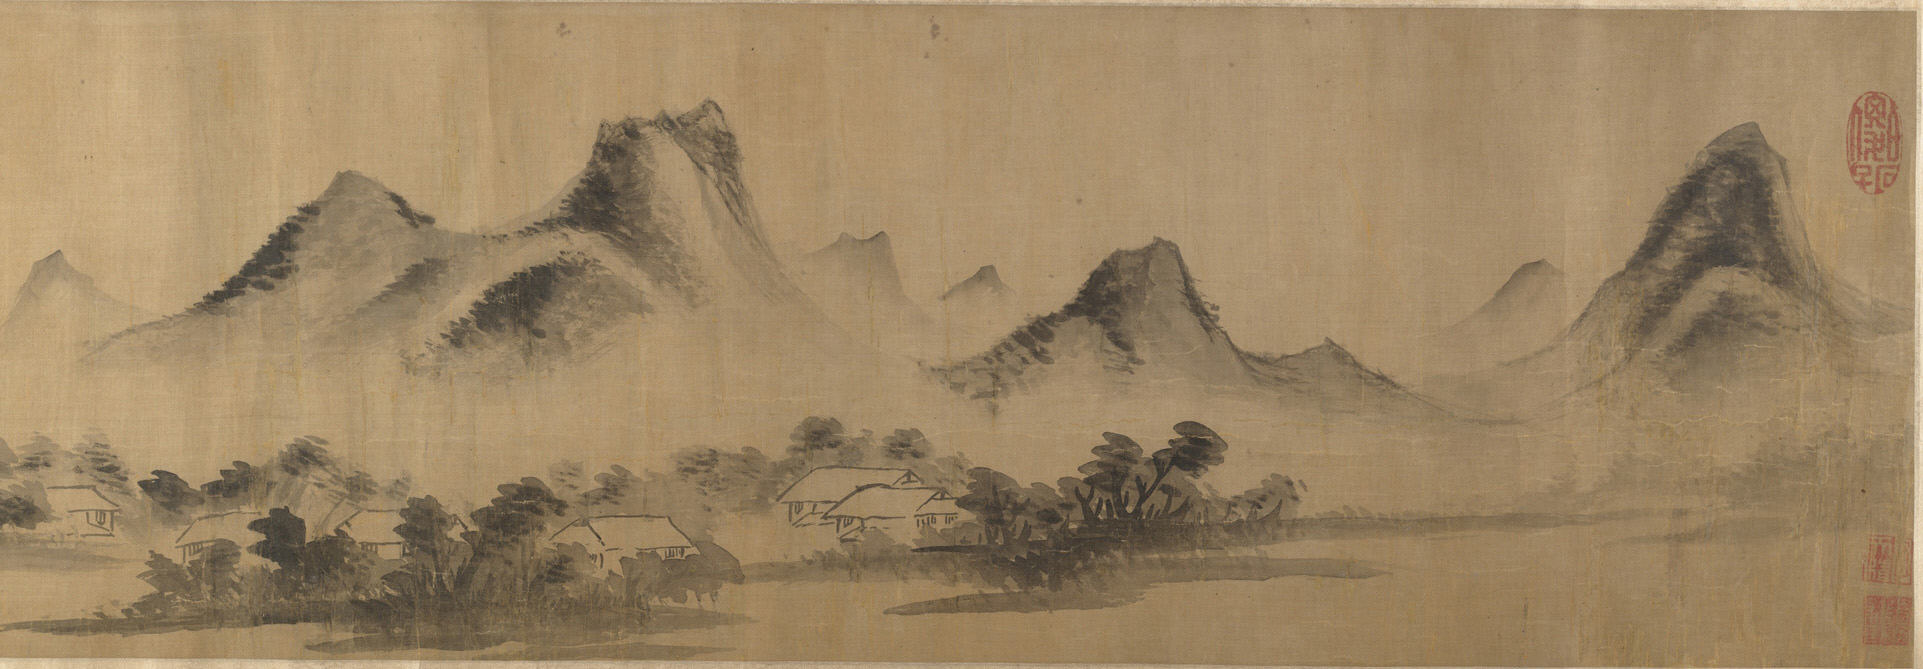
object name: handscroll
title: Cloudy Mountain in the Style of Mi Fu (1052–1107)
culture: chinese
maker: unidentified artist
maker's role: artist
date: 1644-1911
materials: ink, silk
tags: mountains,landscapes